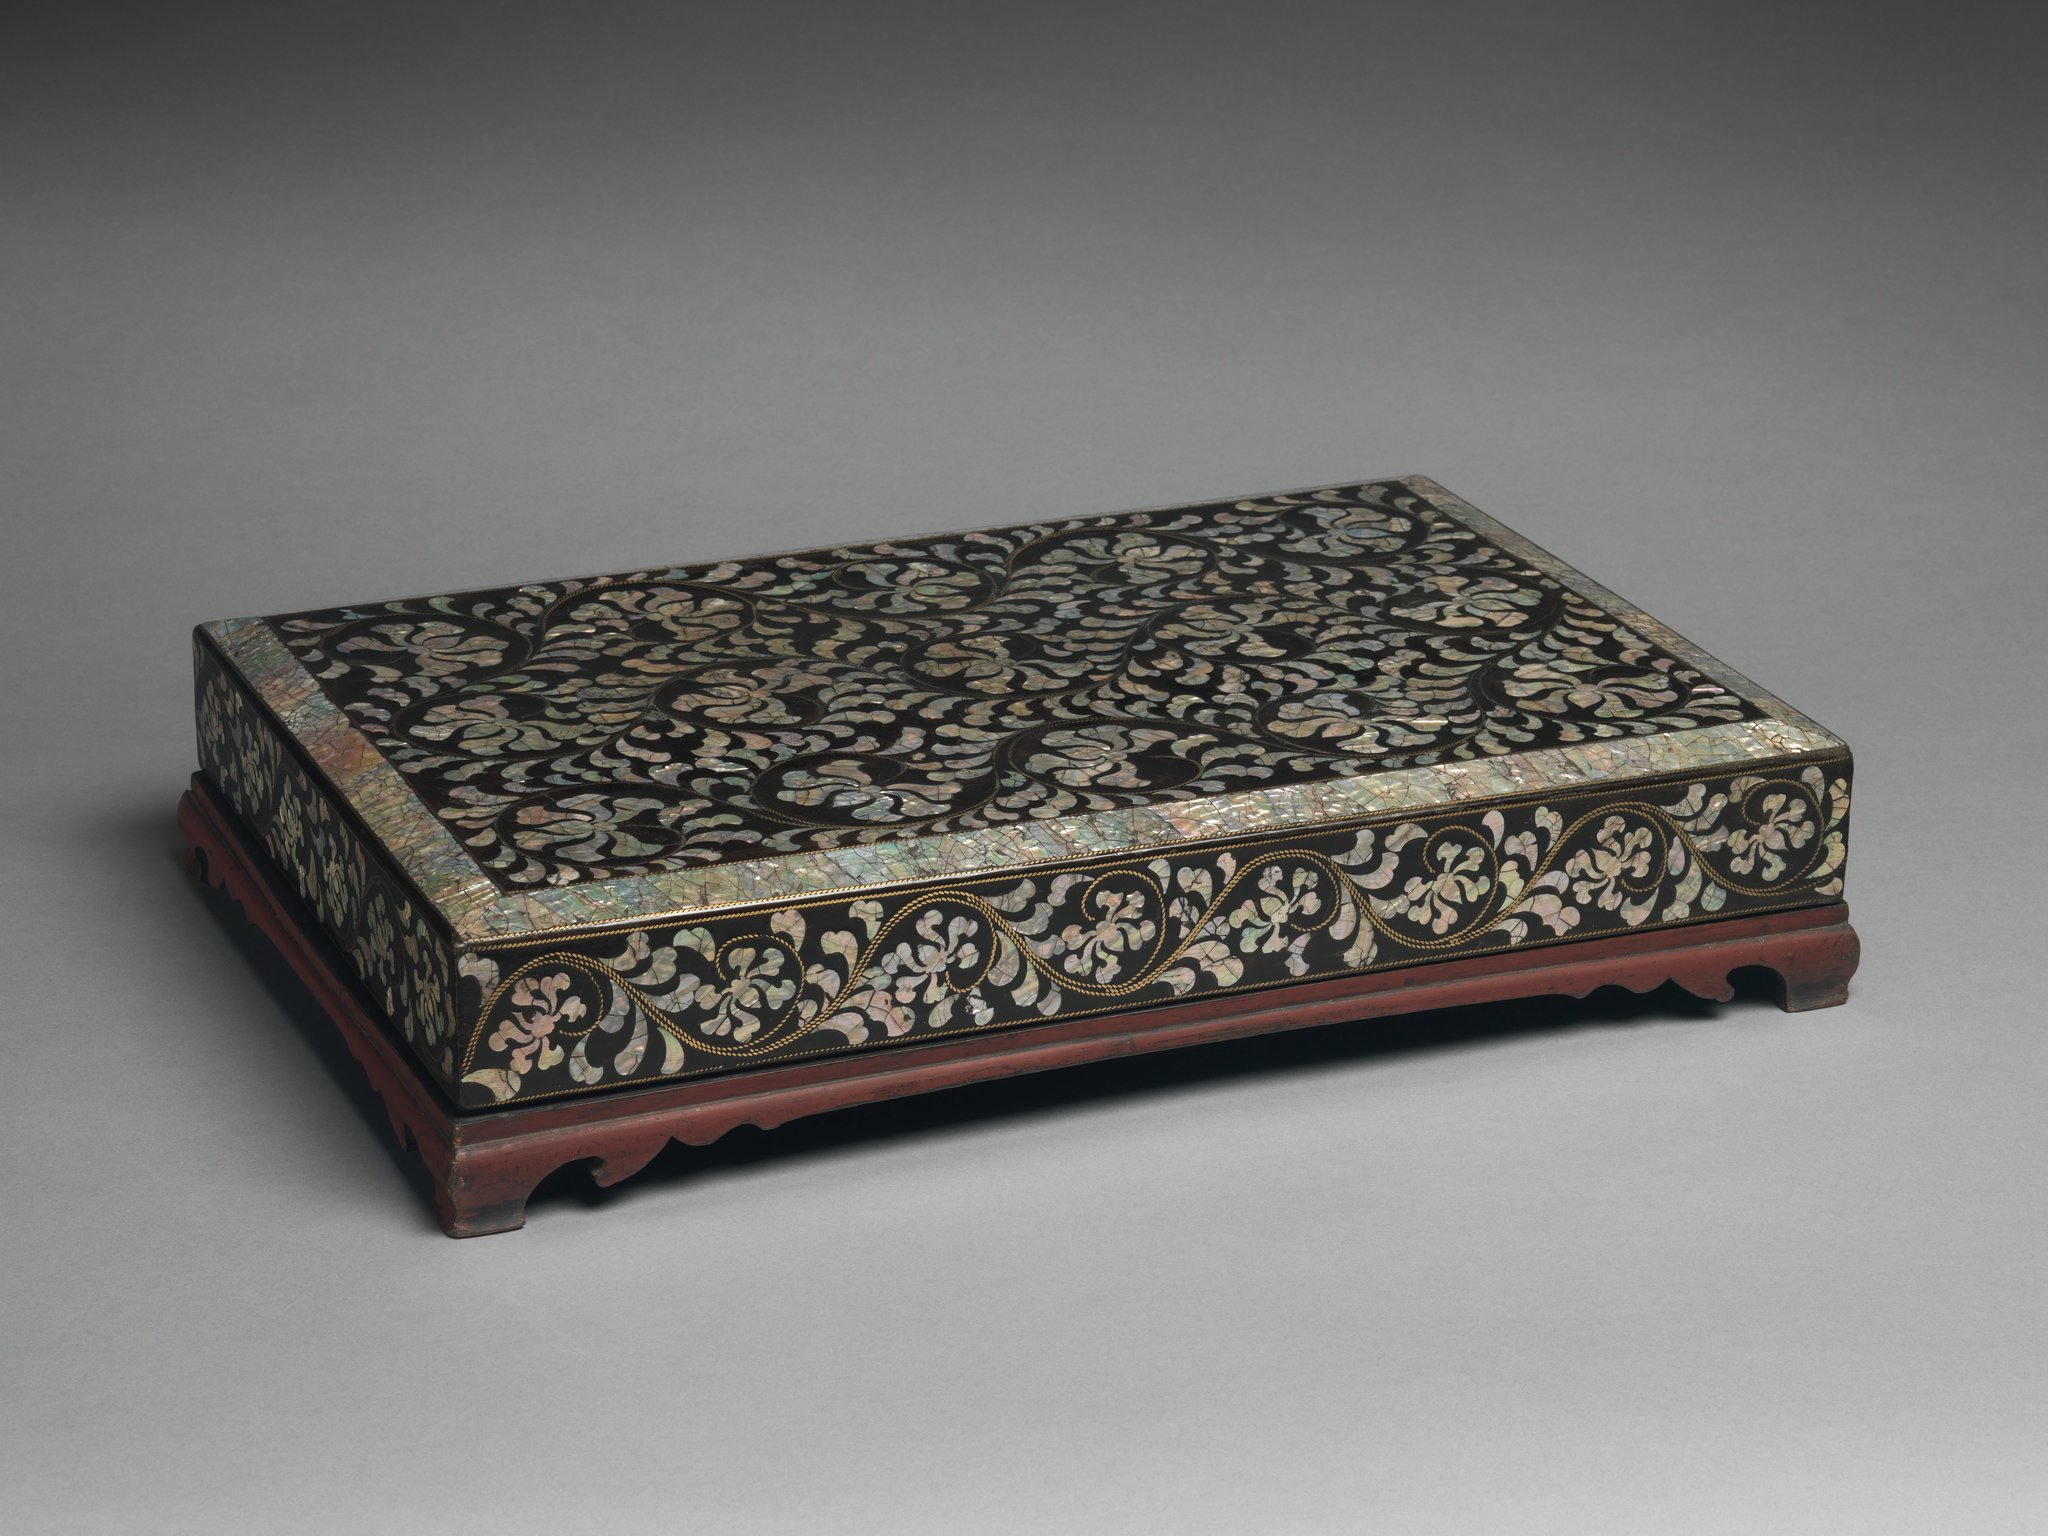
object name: stationery box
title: Stationery box decorated with peony scrolls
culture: korean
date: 1701-1800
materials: lacquer, mother of pearl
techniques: inlay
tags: peonies